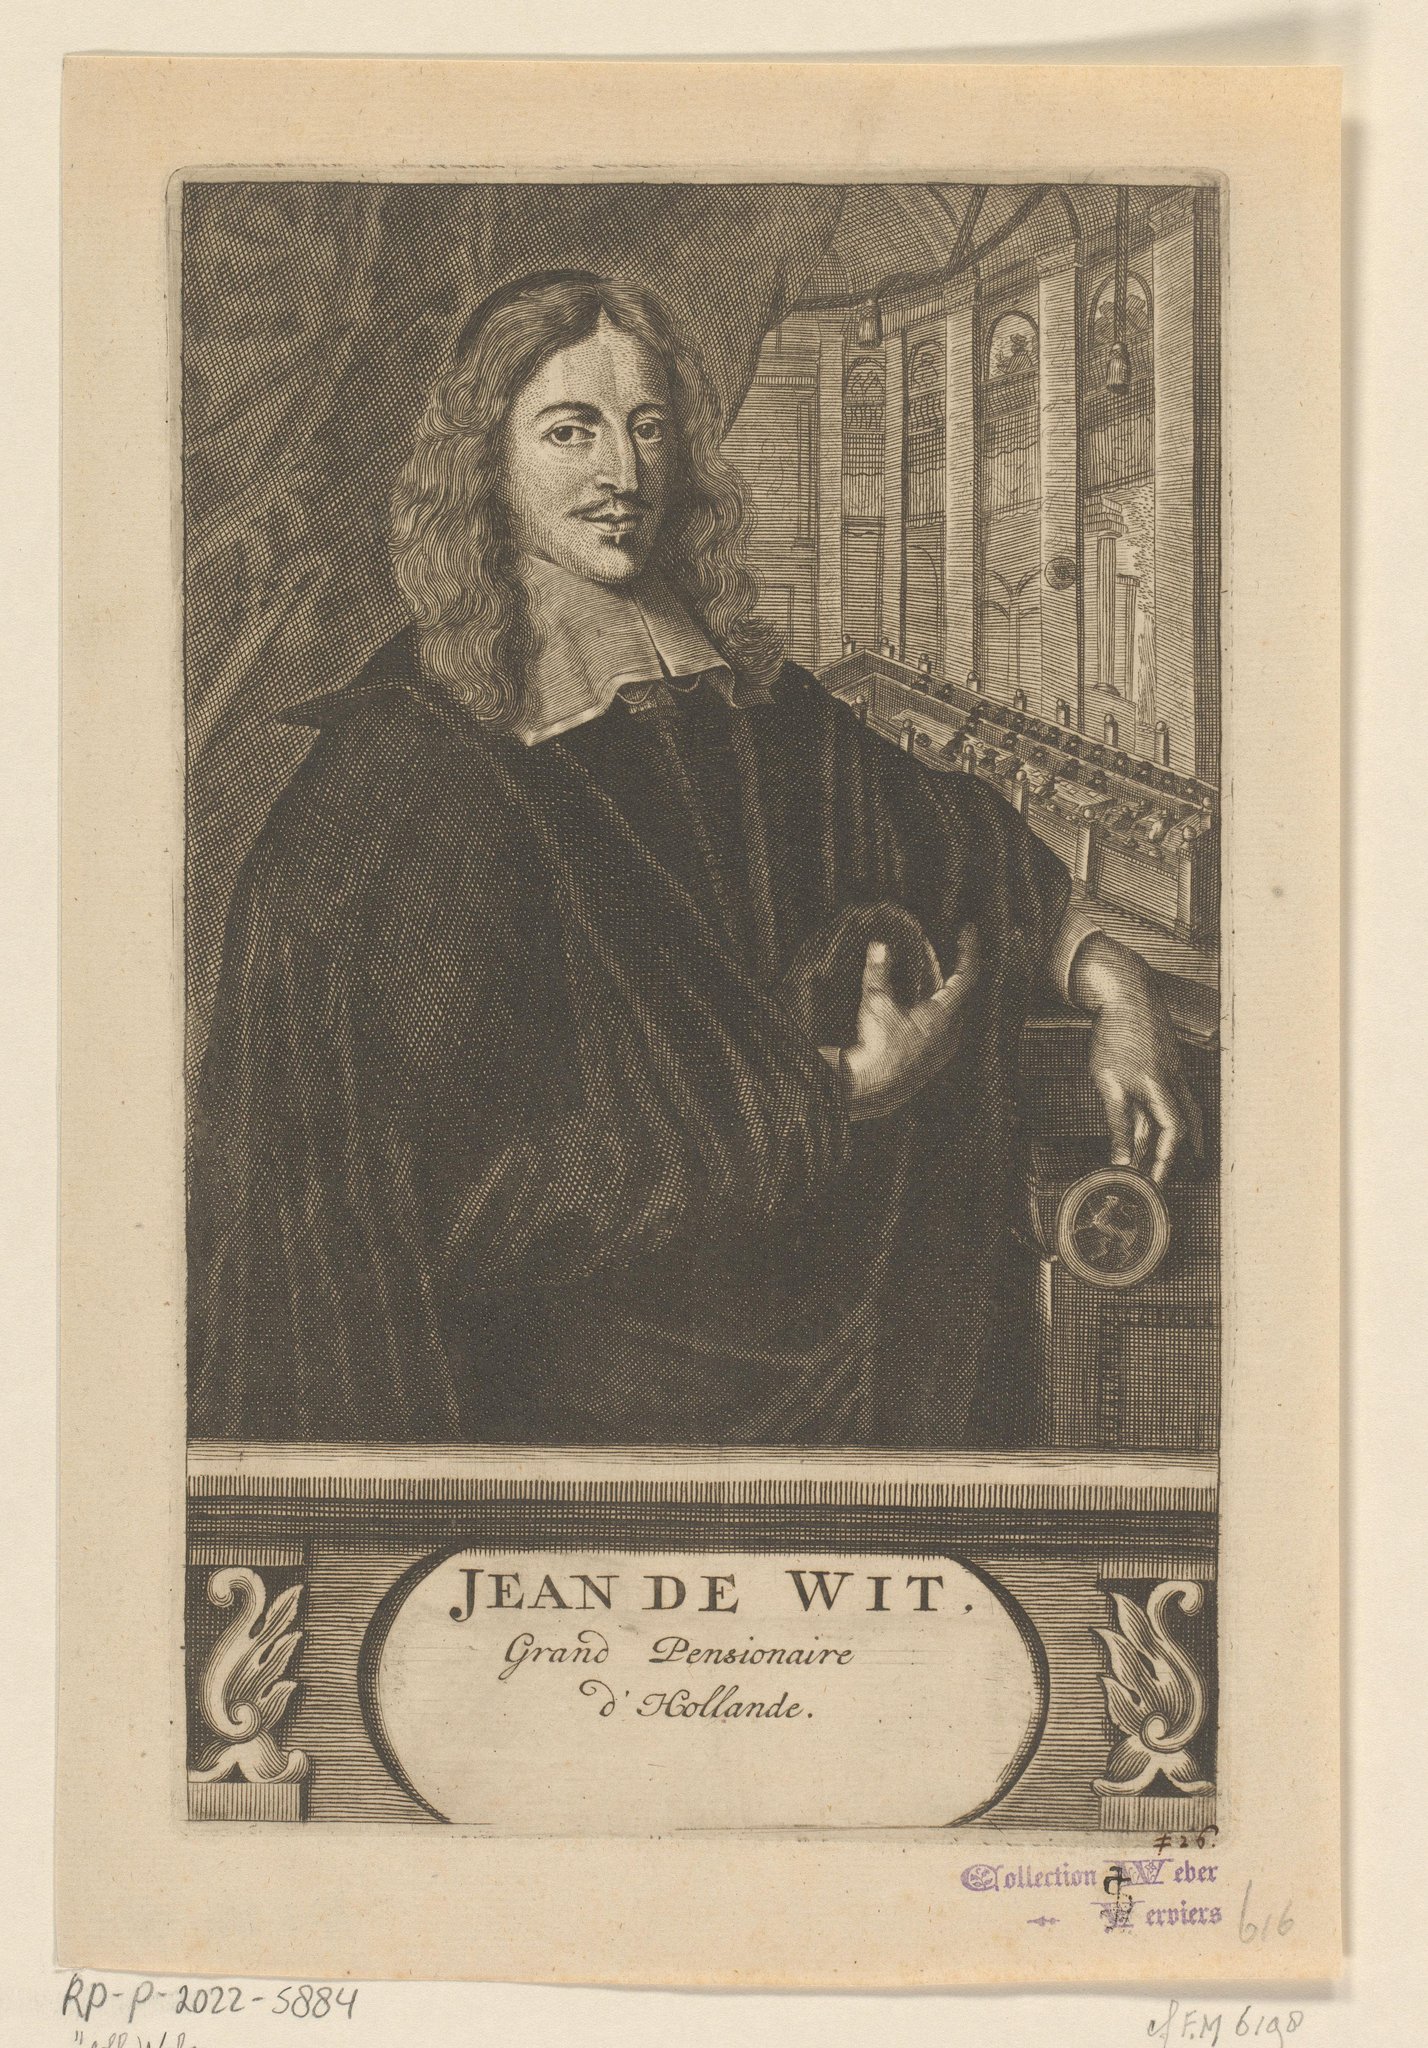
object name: print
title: Portret van Johan de Witt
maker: Anonymous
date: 1650-1700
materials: paper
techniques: engraving, etching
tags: the hague, politician, johan de witt, historical persons, governor, etc. of province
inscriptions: collector's mark: ‘SL’, collector's mark: Lugt 2551b